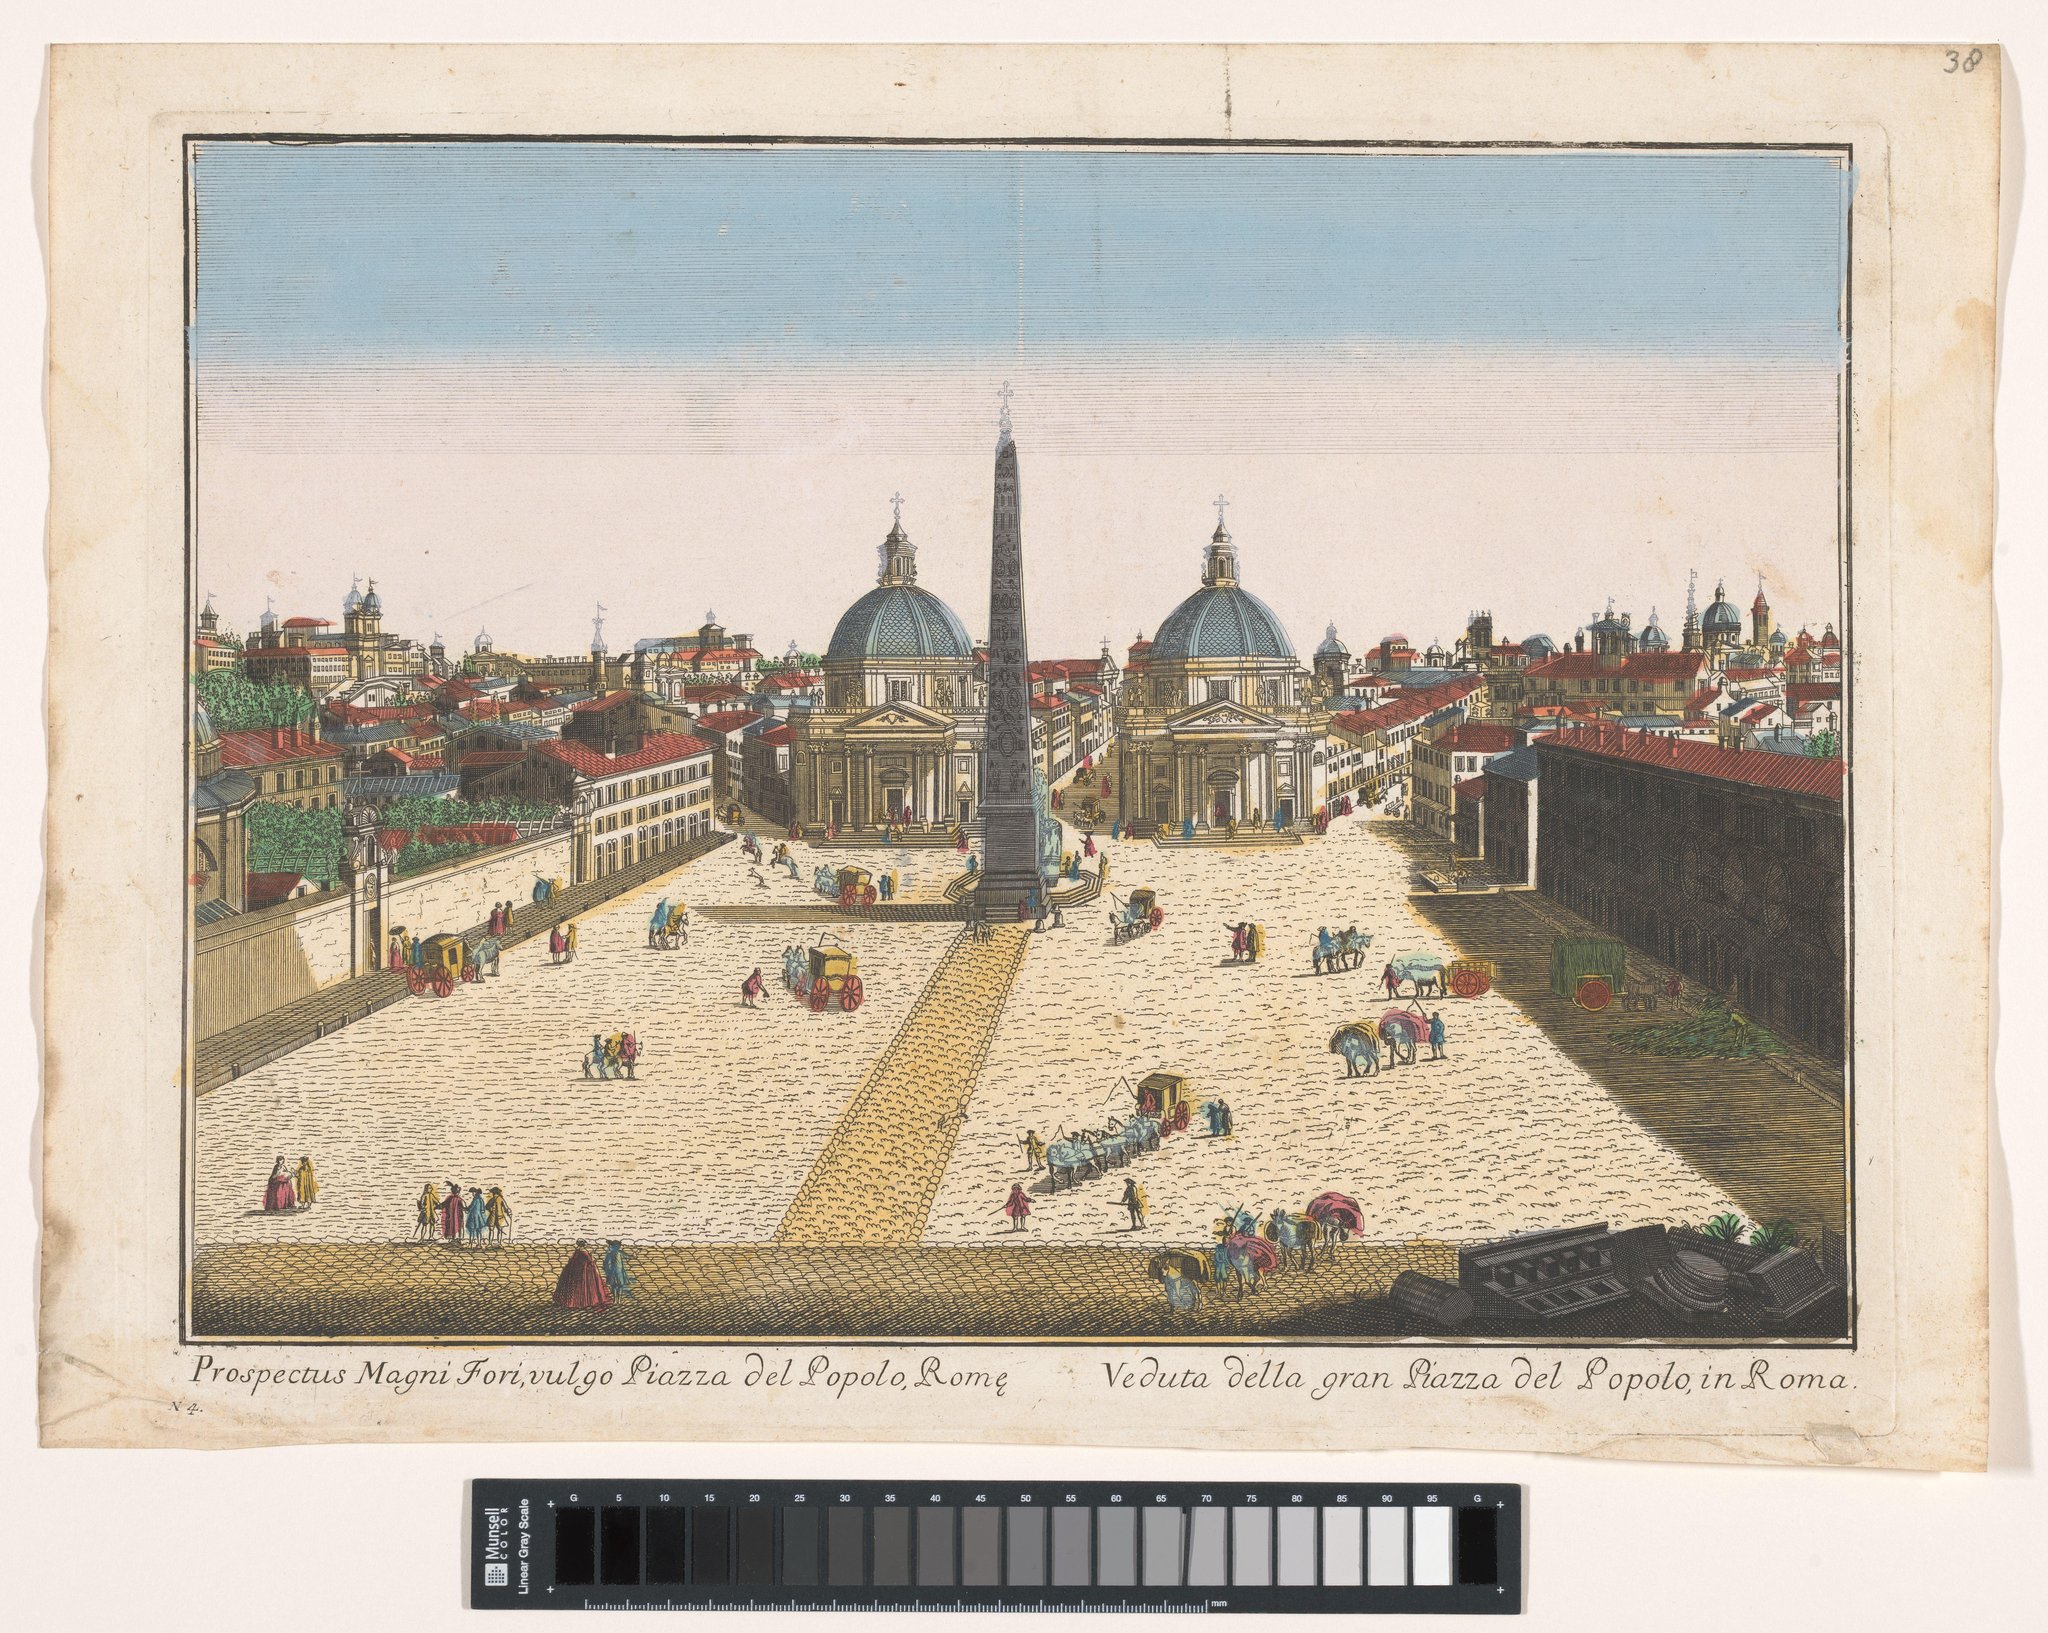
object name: print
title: Gezicht op het Piazza del Popolo te Rome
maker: Anonymous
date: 1700-1799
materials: paper, watercolor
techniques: brush, etching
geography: bassano del grappa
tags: obelisk, needle (+ city(-scape) with figures, staffage), church (exterior), square, place, circus, etc. (+ city(-scape) with figures, staffage), ornamental fountain (+ city(-scape) with figures, staffage)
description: Aan het plein staat links de kerk Santa Maria in Montesanto en rechts de kerk Santa Maria dei Miracoli. Linksonder genummerd: N 4.